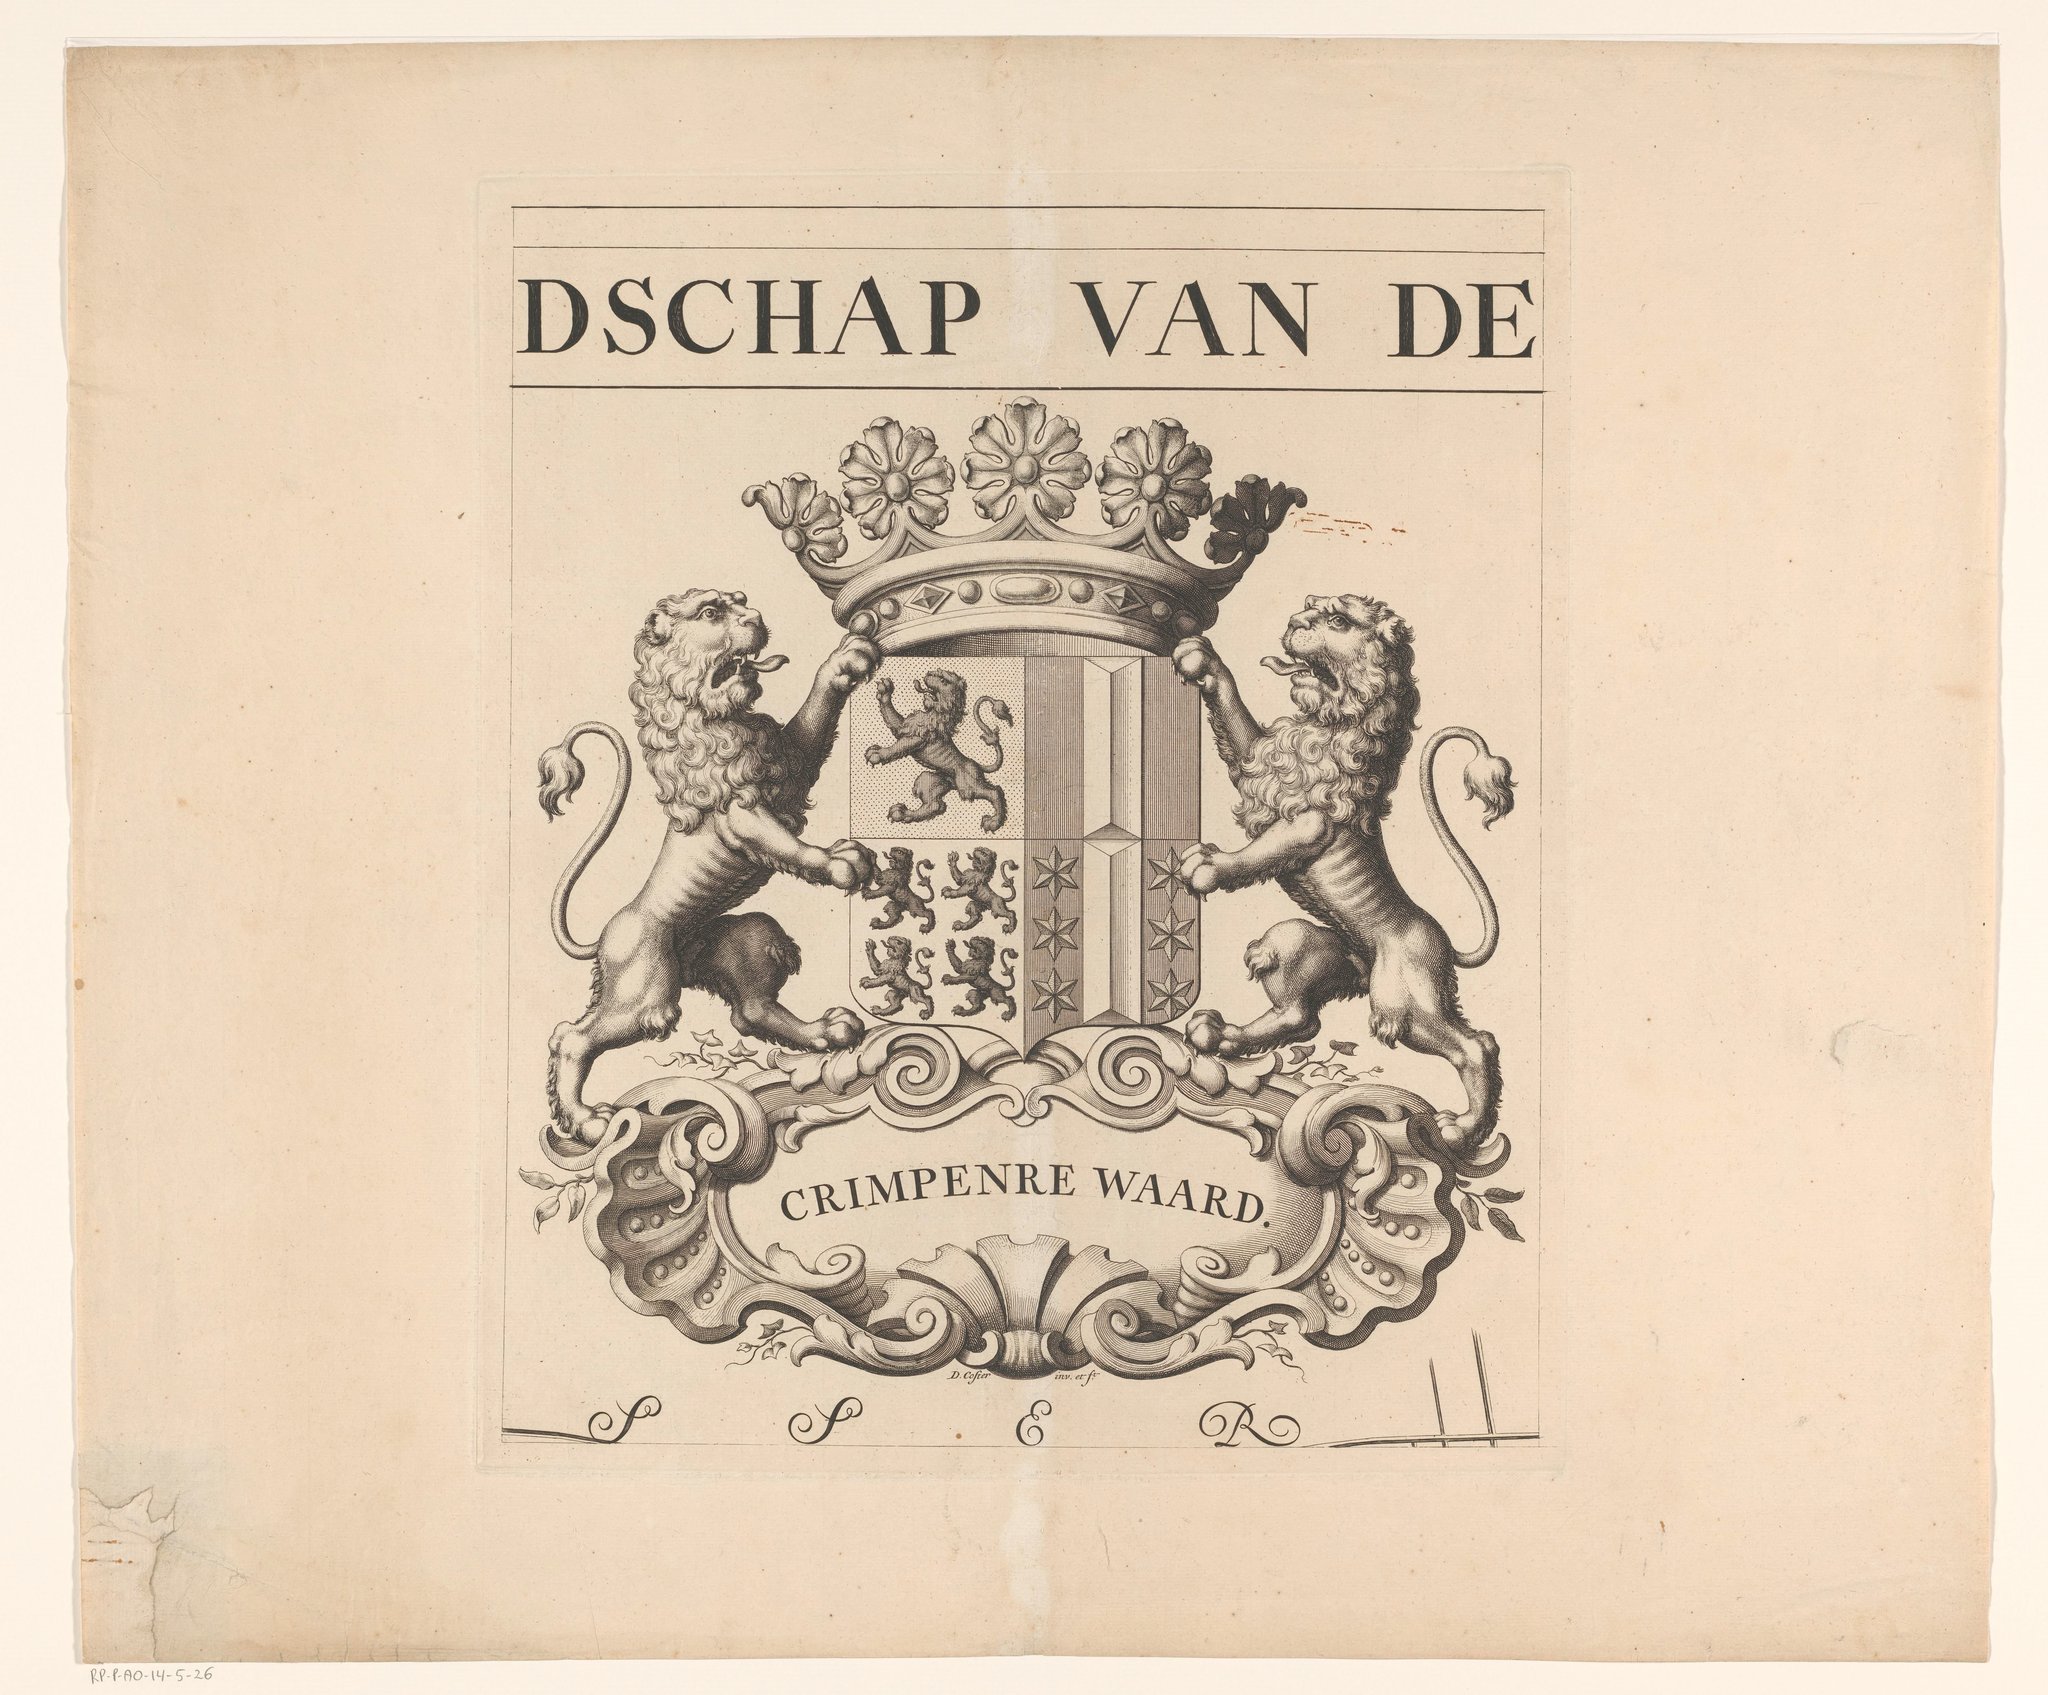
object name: print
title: Kaart van het Hoogheemraadschap van de Krimpenerwaard (deel wapenrand)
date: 1683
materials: paper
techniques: engraving, etching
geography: amsterdam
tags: coat of arms (as symbol of the state, etc.), maps of separate countries or regions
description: Deel van de wapenrand van de vijfde druk van 'Het Hooge Heemraadschap van de Crimpenre Waard', een wandkaart (bestaande uit een kaart en een wapenrand) van het Hoogheemraadschap van de Krimpenerwaard.